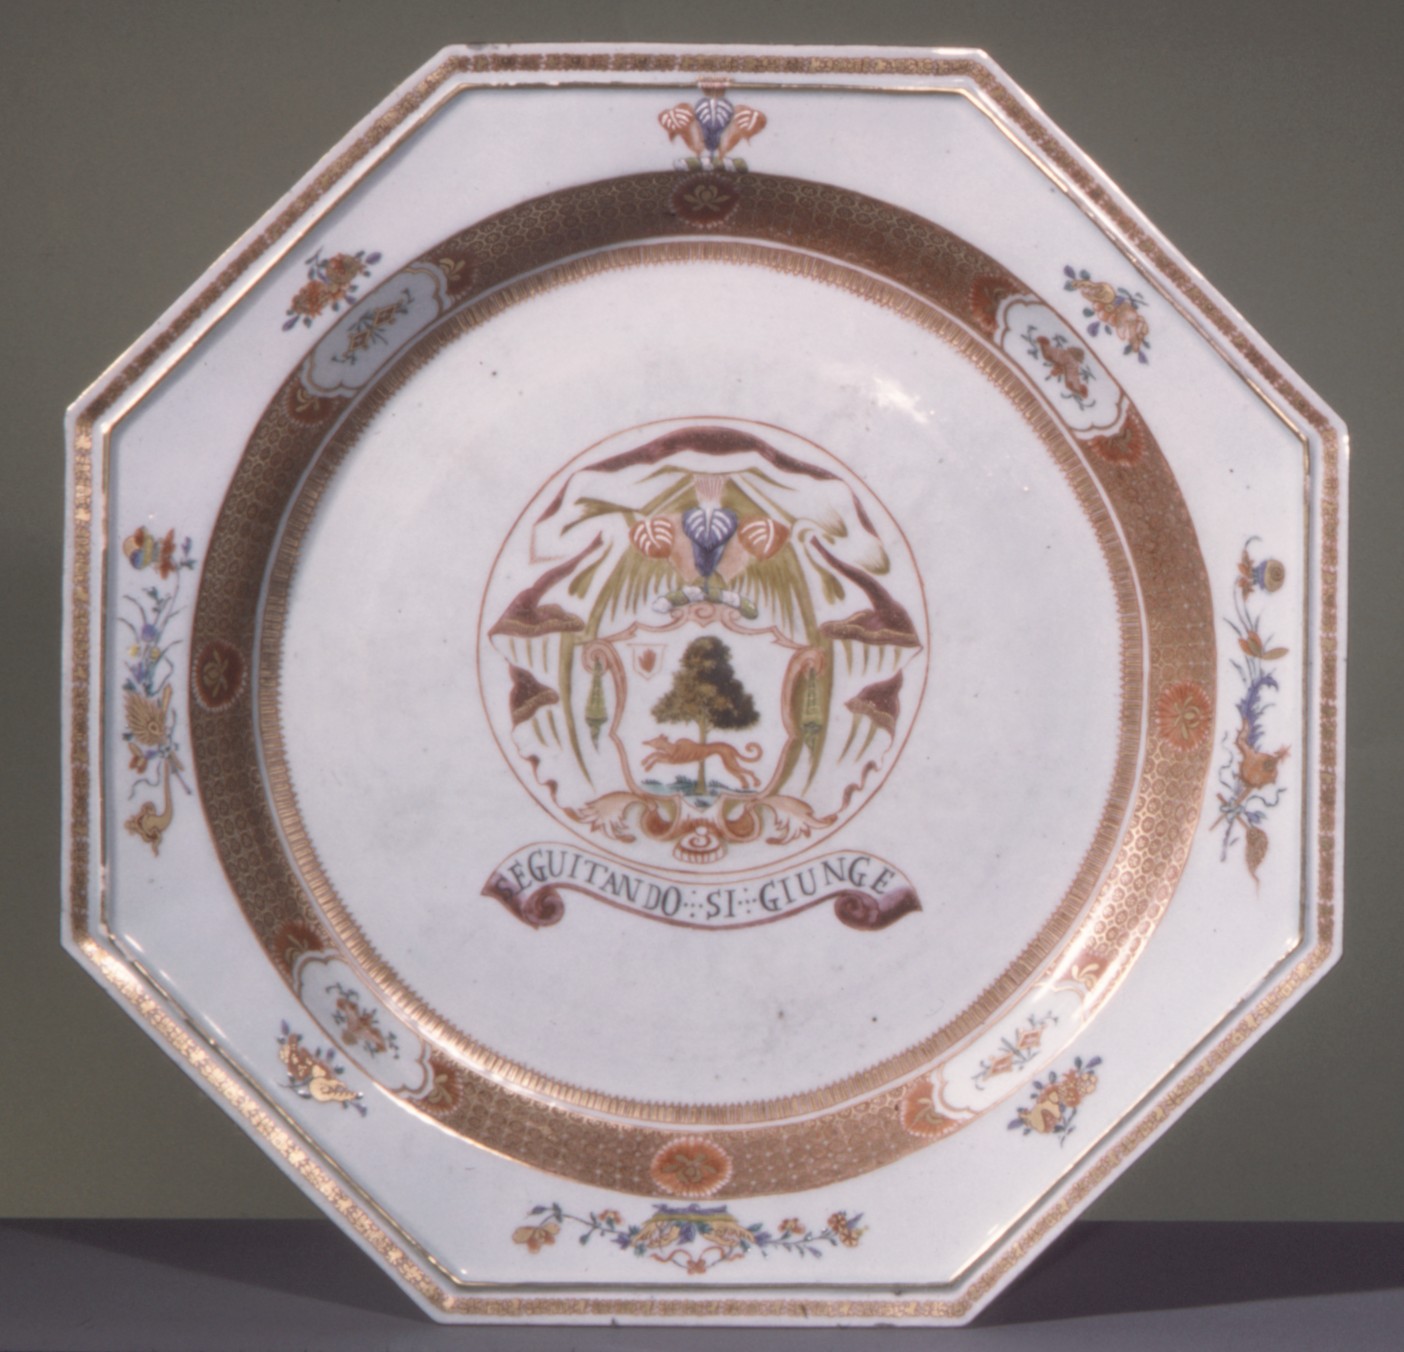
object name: charger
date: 1720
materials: hard paste porcelain